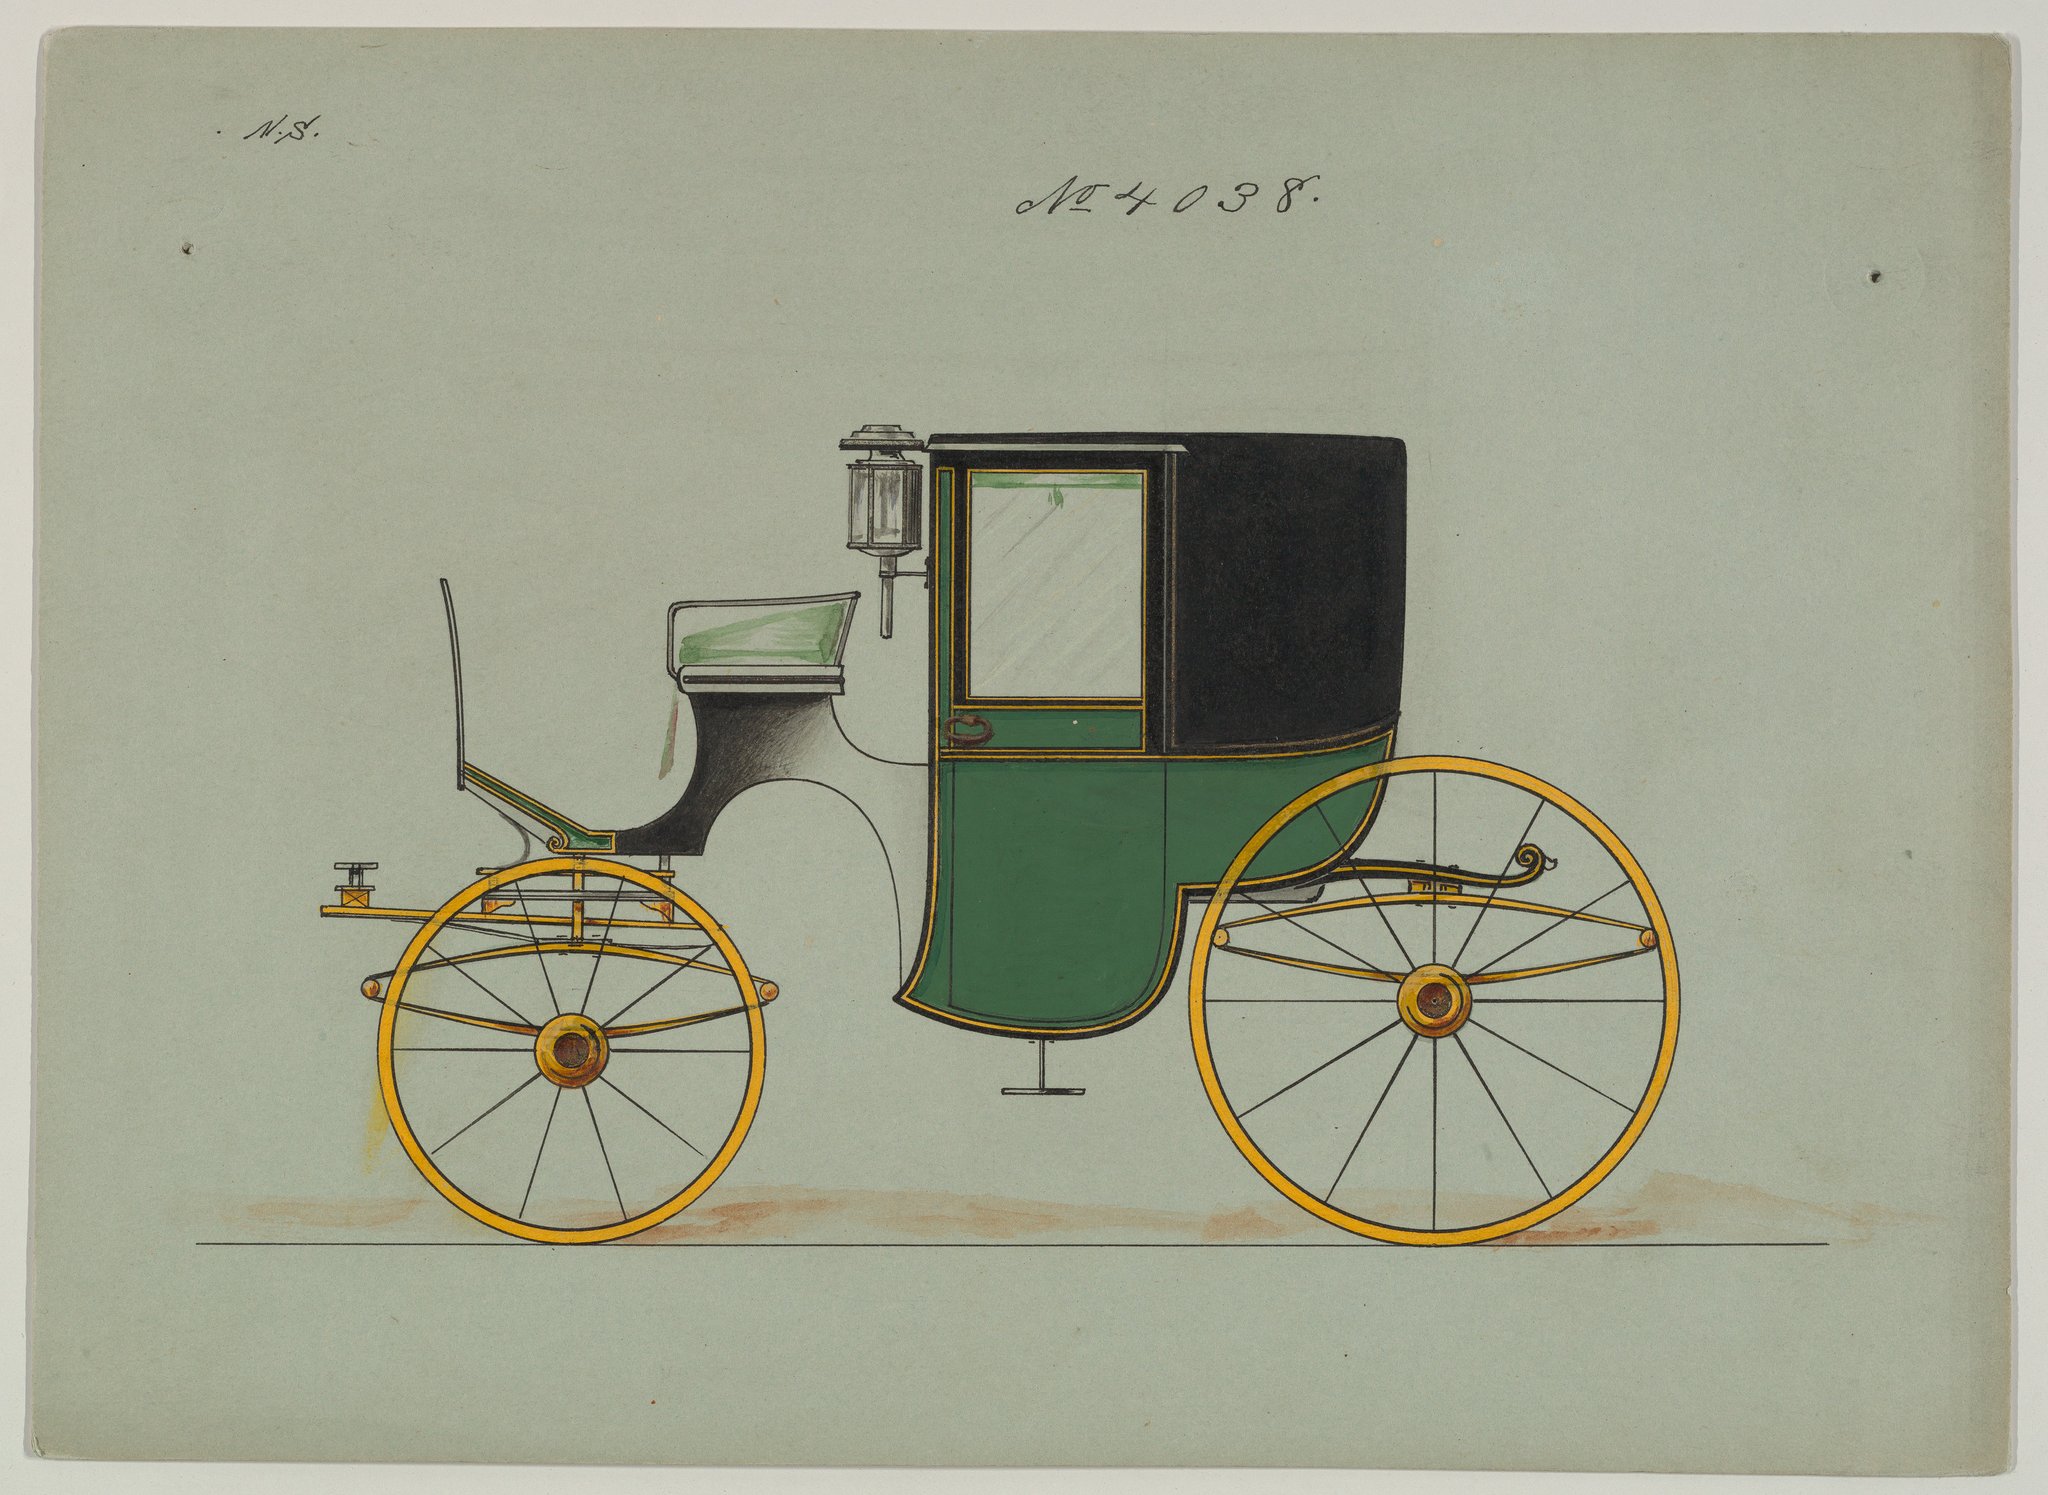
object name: drawing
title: Brougham #4038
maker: brewster & co.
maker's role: manufacturer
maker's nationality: american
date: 1889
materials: gouache, gum arabic, ink, watercolor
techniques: pen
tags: carriages